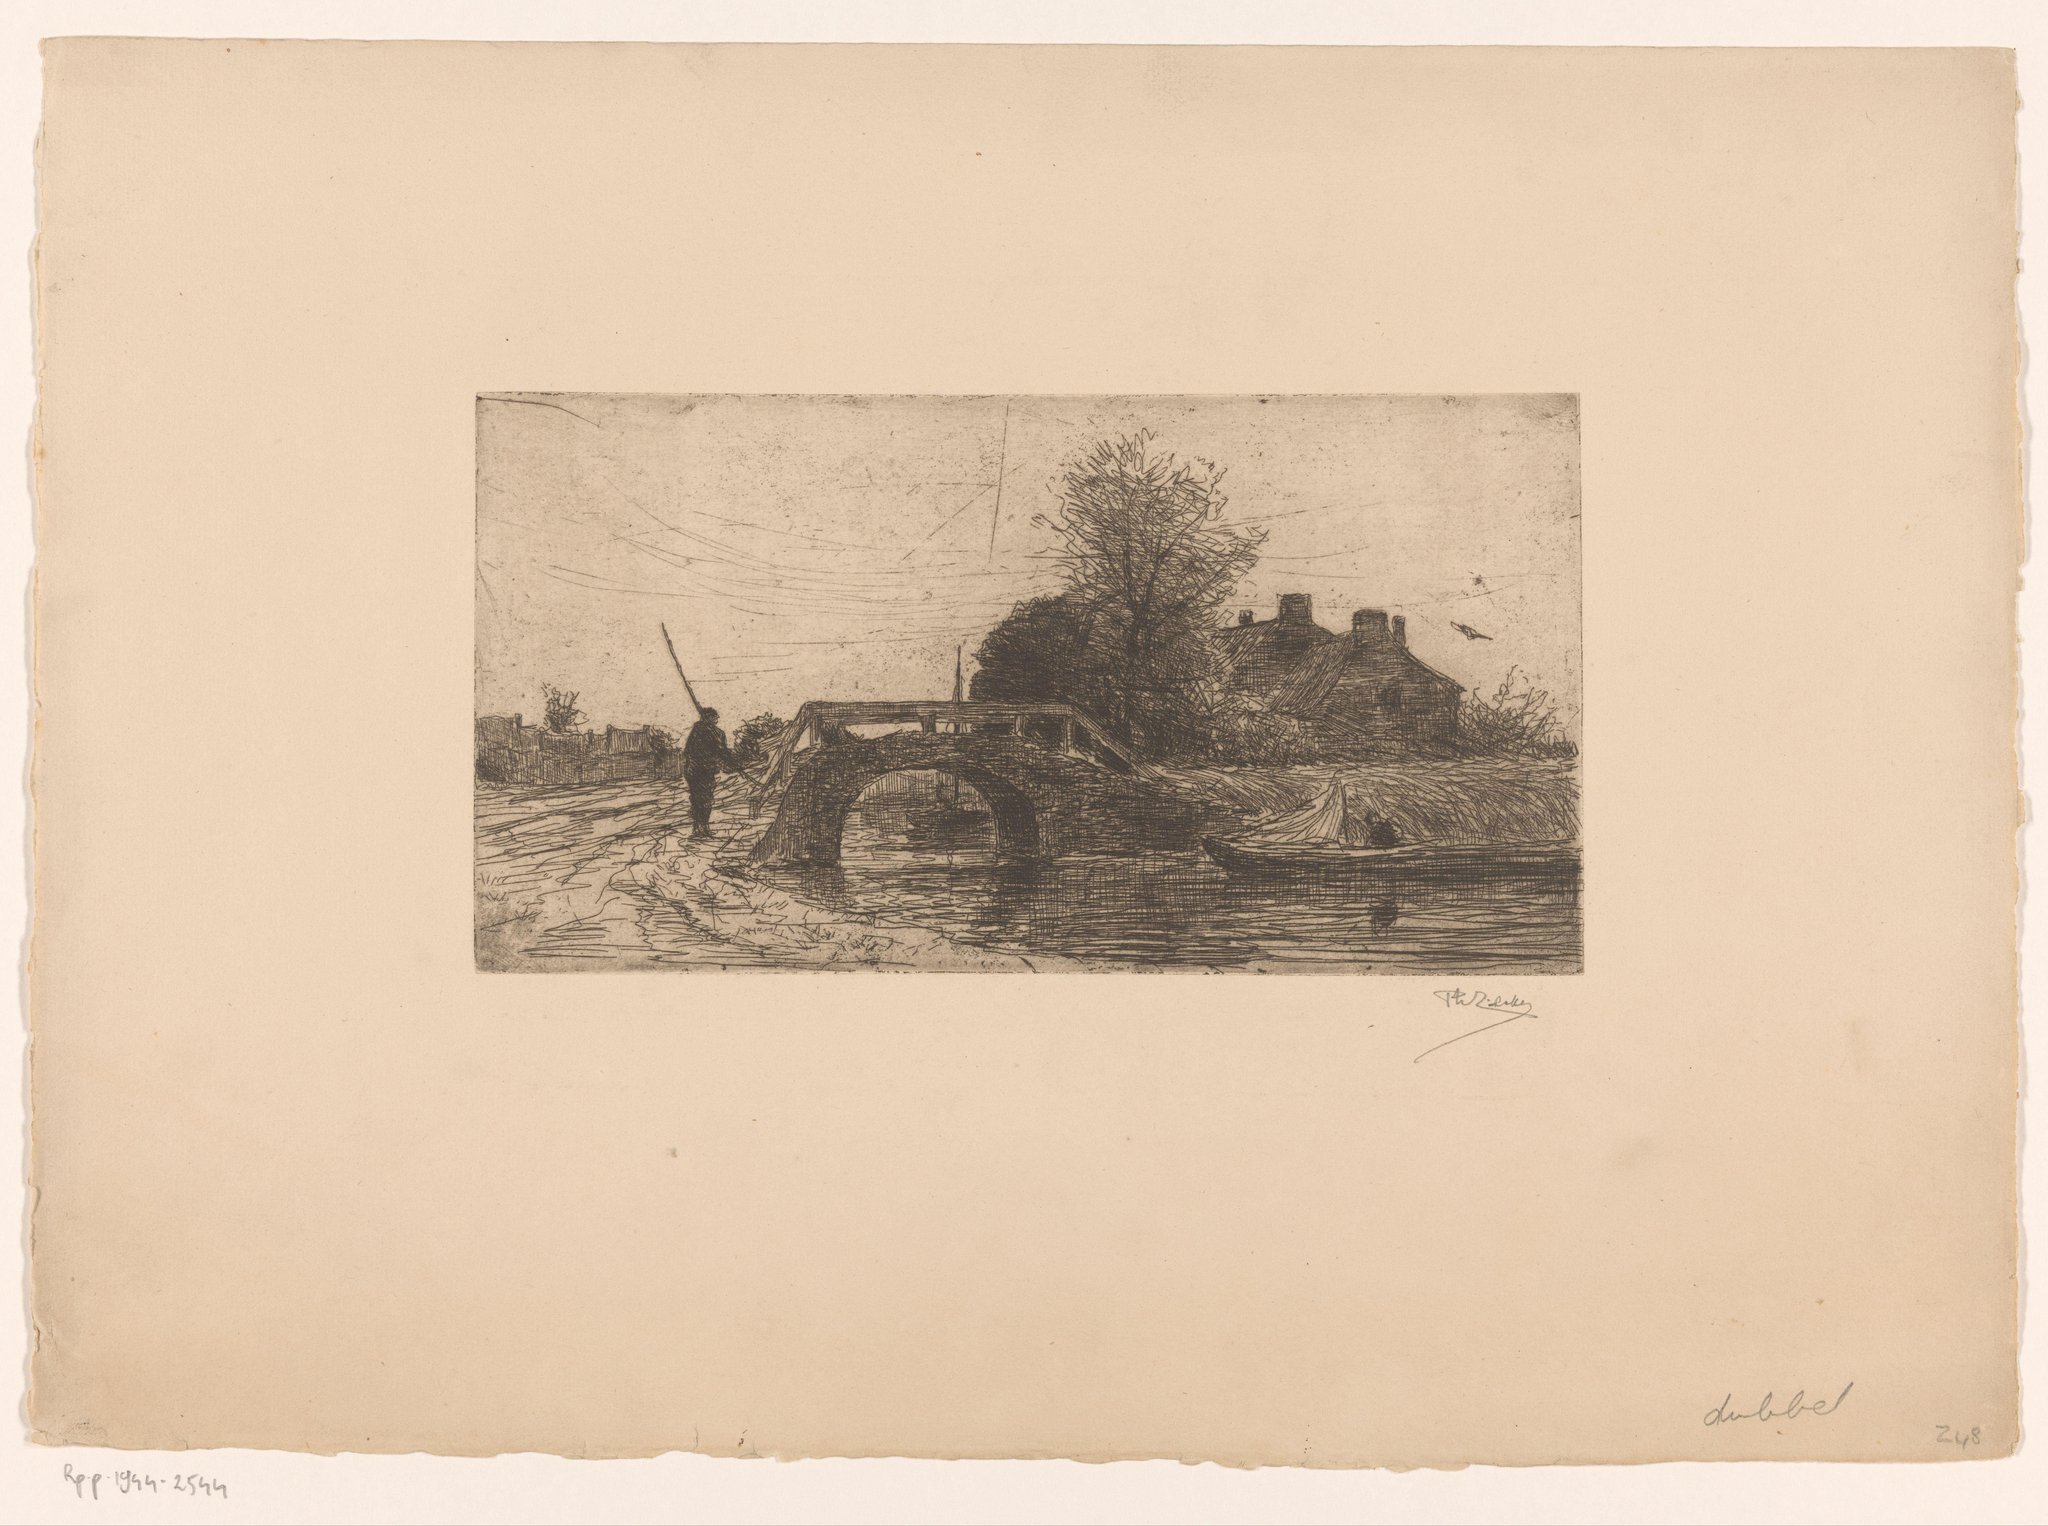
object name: print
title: Primavera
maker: philip zilcken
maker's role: draughtsman, painter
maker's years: 1857-1930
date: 1890-1930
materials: paper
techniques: etching, intaglio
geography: amsterdam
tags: river, bridge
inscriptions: collector's mark: Lugt 2228